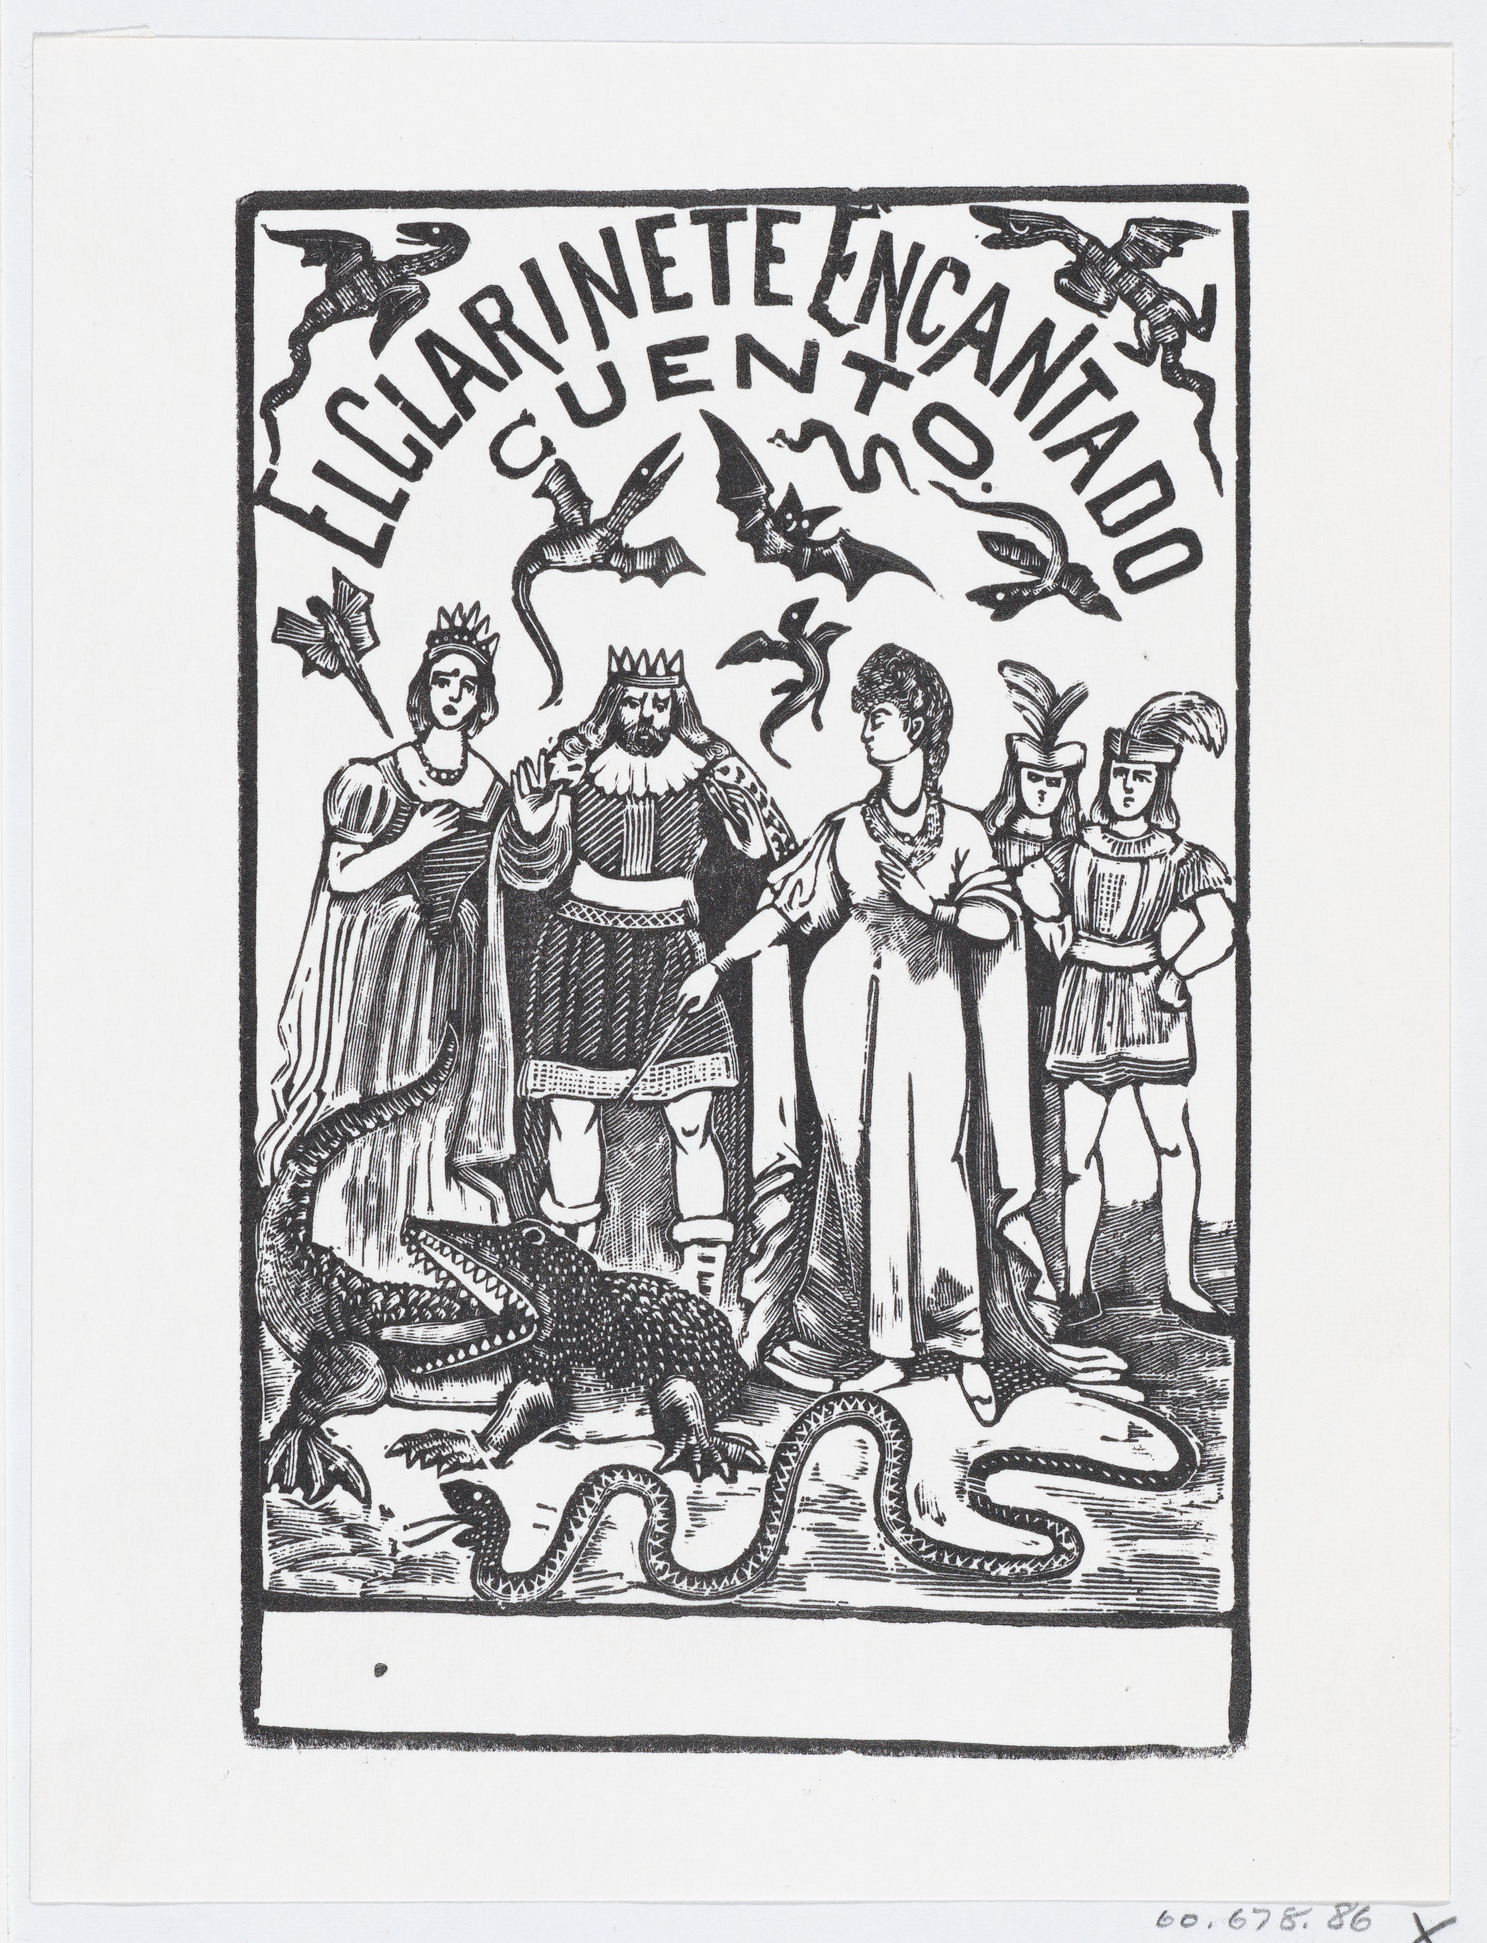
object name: print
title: A sorceress pointing her wand at a crocodile while royal figures watch, illustration for 'El Clarinete Encantado'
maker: josé guadalupe posada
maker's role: artist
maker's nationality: mexican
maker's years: 1852-1913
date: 1890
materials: metal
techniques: engraving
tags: bats,men,women,crocodiles,snakes